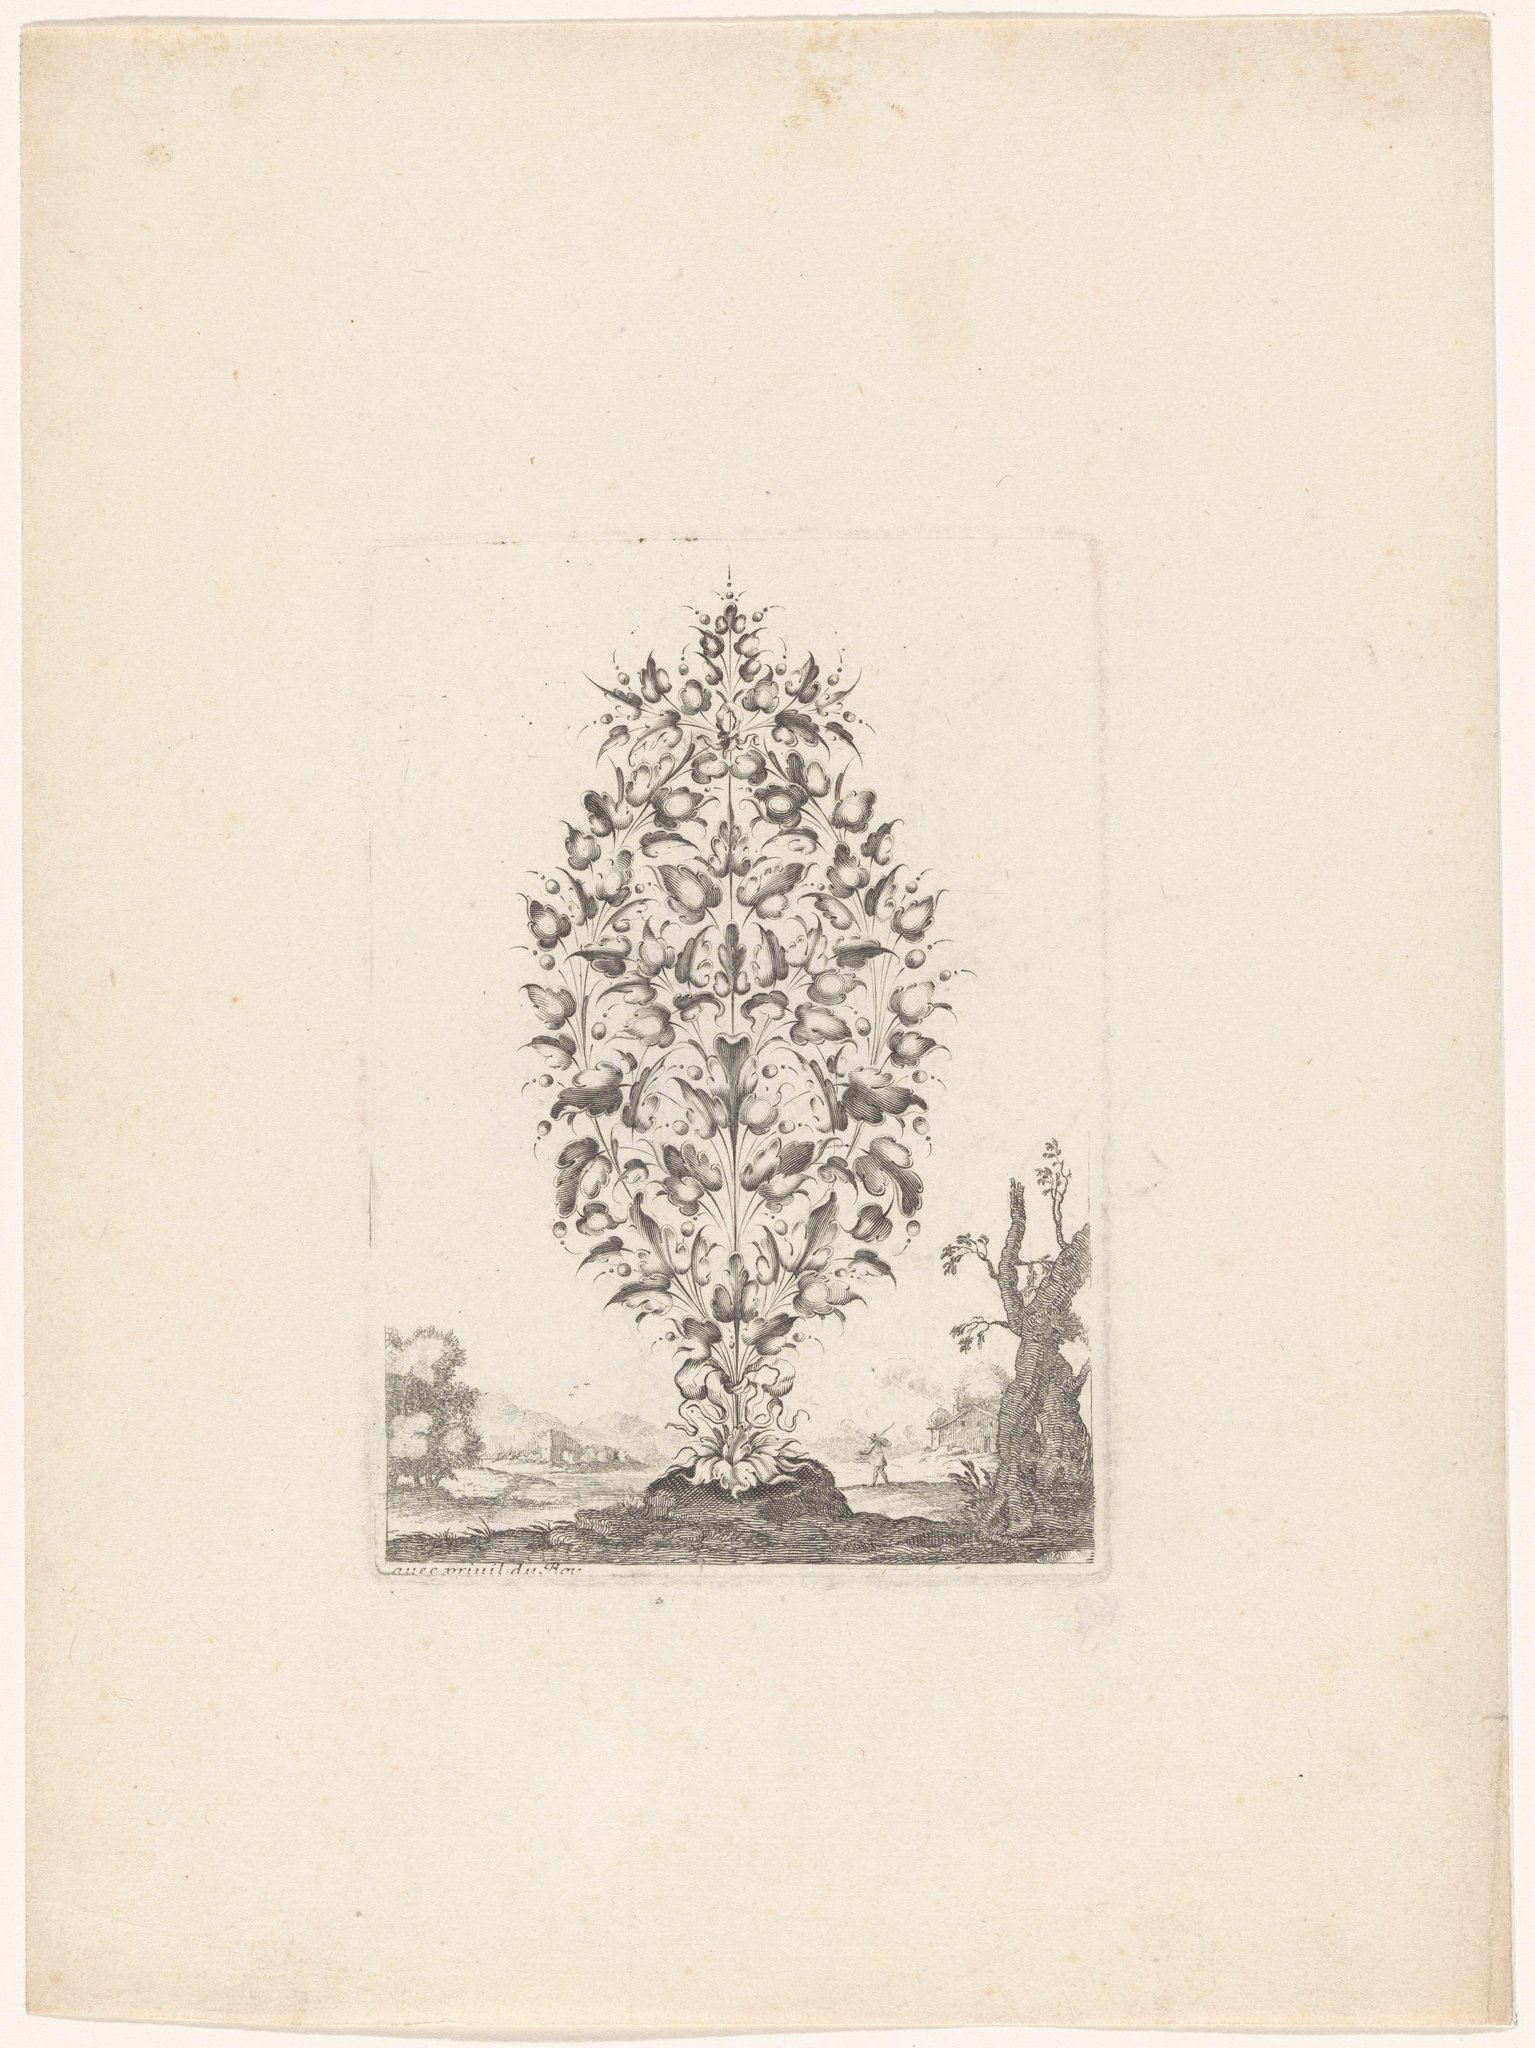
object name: ornament print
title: Livre de Feuilles d'Orfevrerie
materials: paper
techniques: etching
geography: paris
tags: rosette ~ ornament, trees, ornaments ~ art, branches, 'astwerk' ~ ornament, 'en route', traveller under way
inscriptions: collector's mark: Lugt 2228, collector's mark: Lugt 2760, collector's mark: Lugt 895a, privilege: ‘avec privil du Roy’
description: Blad uit serie van zeven bladen met edelsmidboeketten. Boeket in 'cosses-de-pois'-stijl in de vorm van een ovaal, bestaande uit drie takken die elkaar bovenaan kruisen en voortkomen uit een bladrozet; onderaan een landschap met rechts een paar bomen, waarvan er een een vertakte tak heeft, en een reiziger.